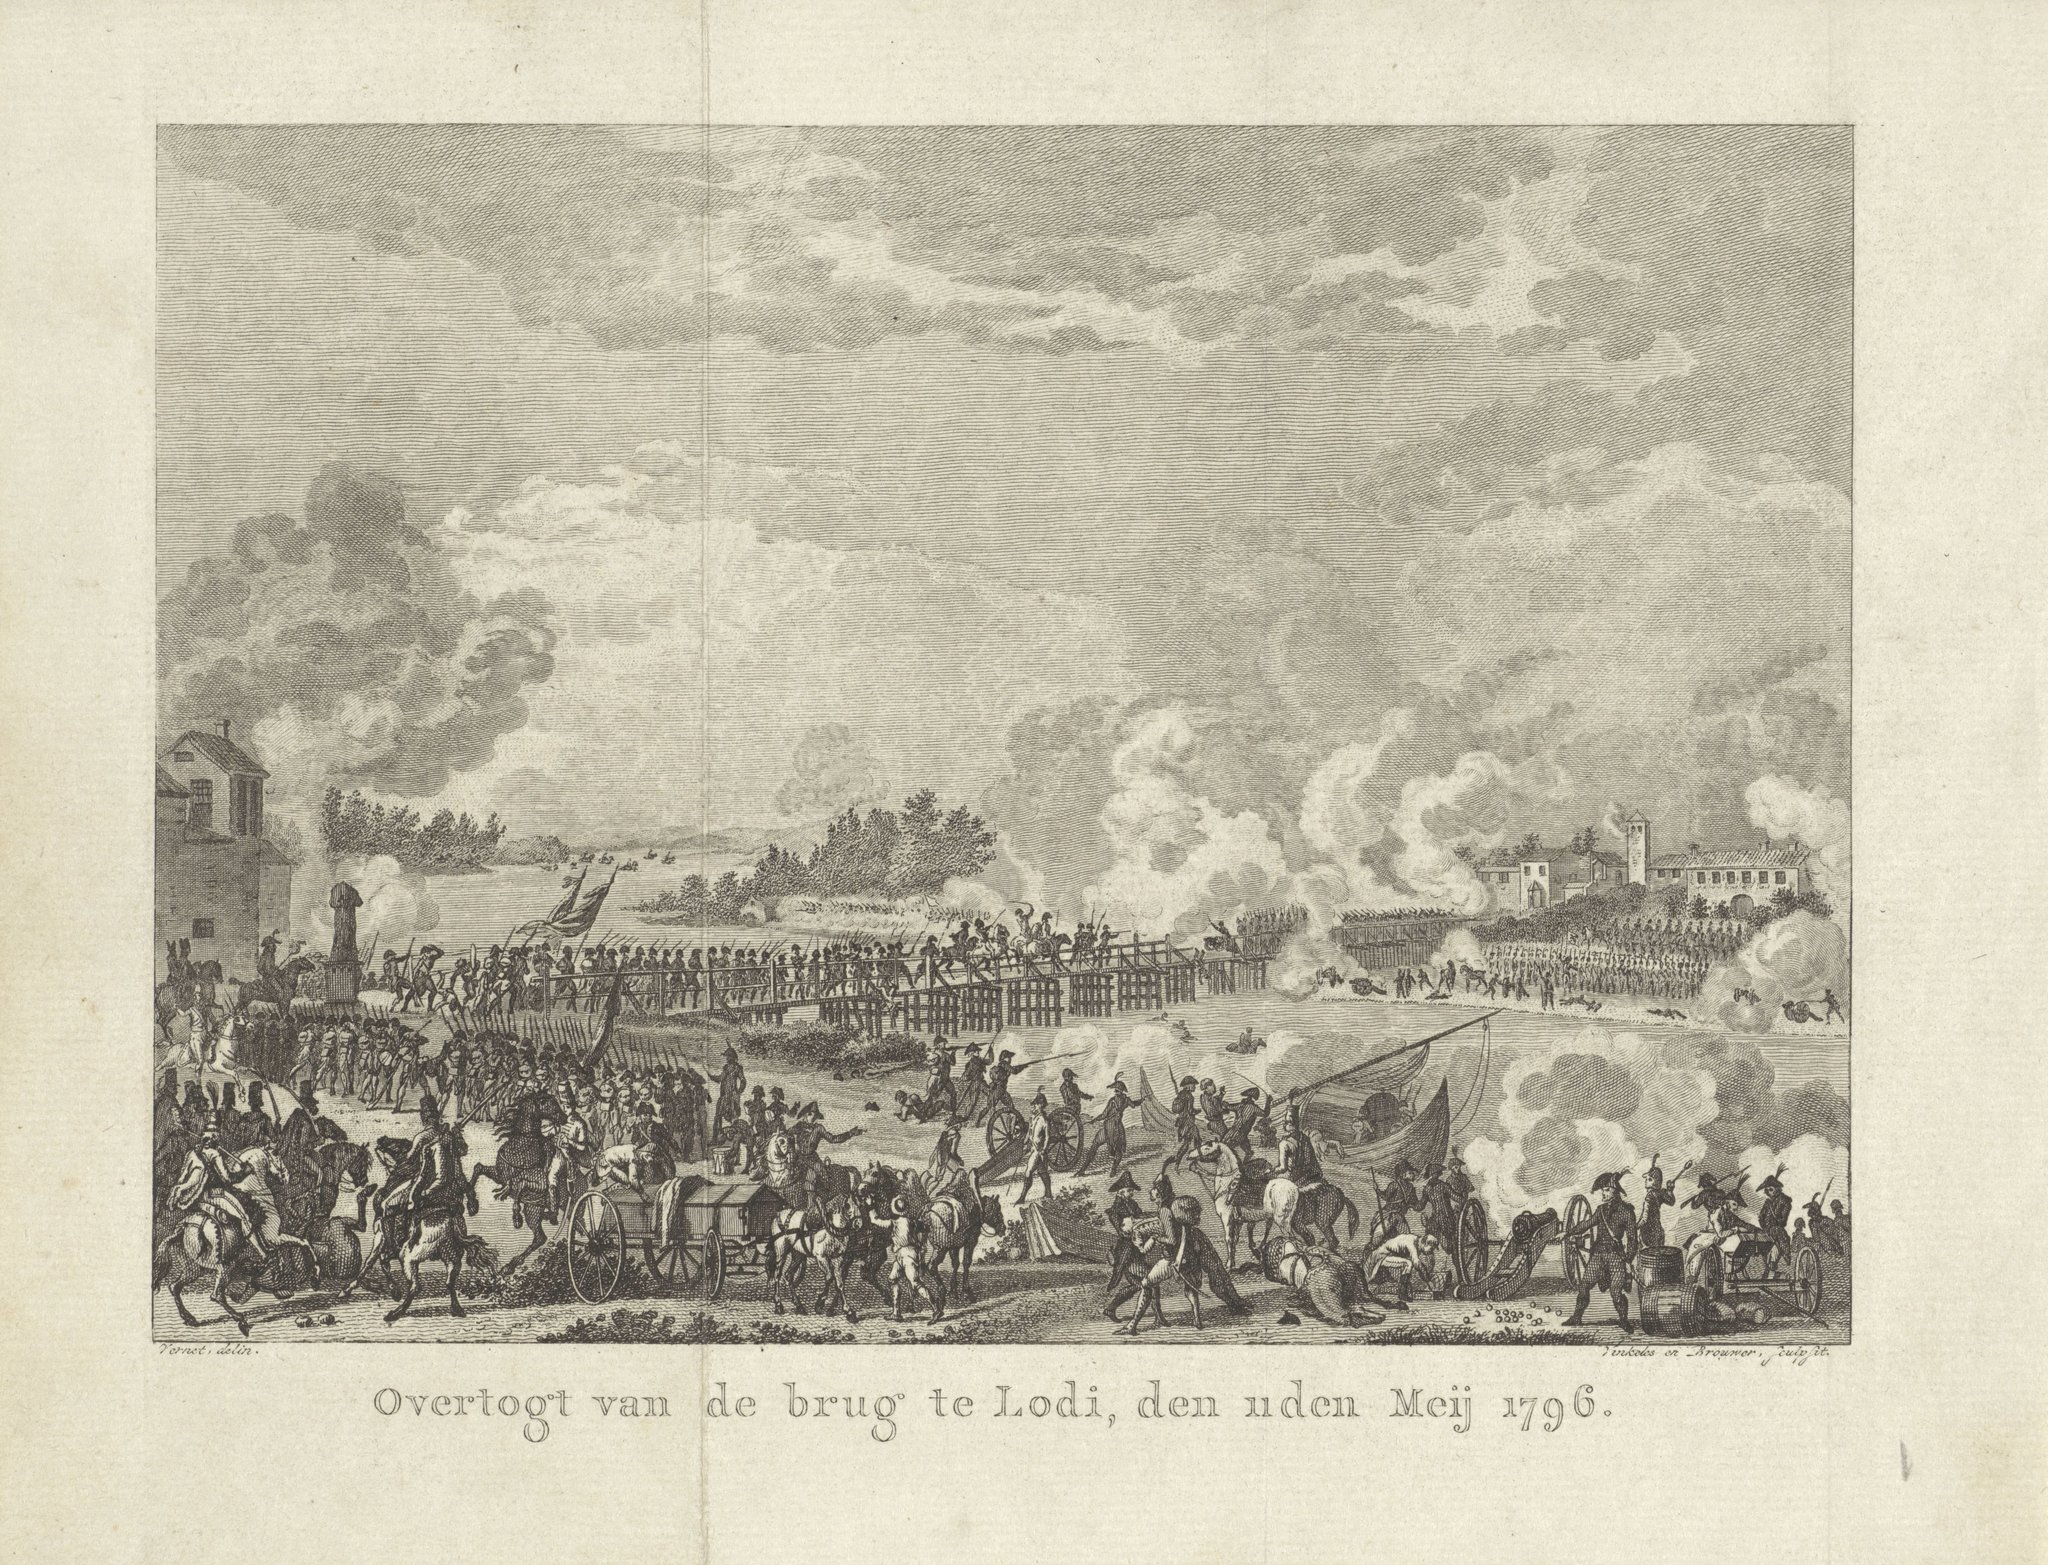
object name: history print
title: Overtogt van de brug te Lodi, den 11den Meij 1796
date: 1796-1798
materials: paper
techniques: engraving, etching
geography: amsterdam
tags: battle (+ land forces)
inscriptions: collector's mark: Lugt 2228